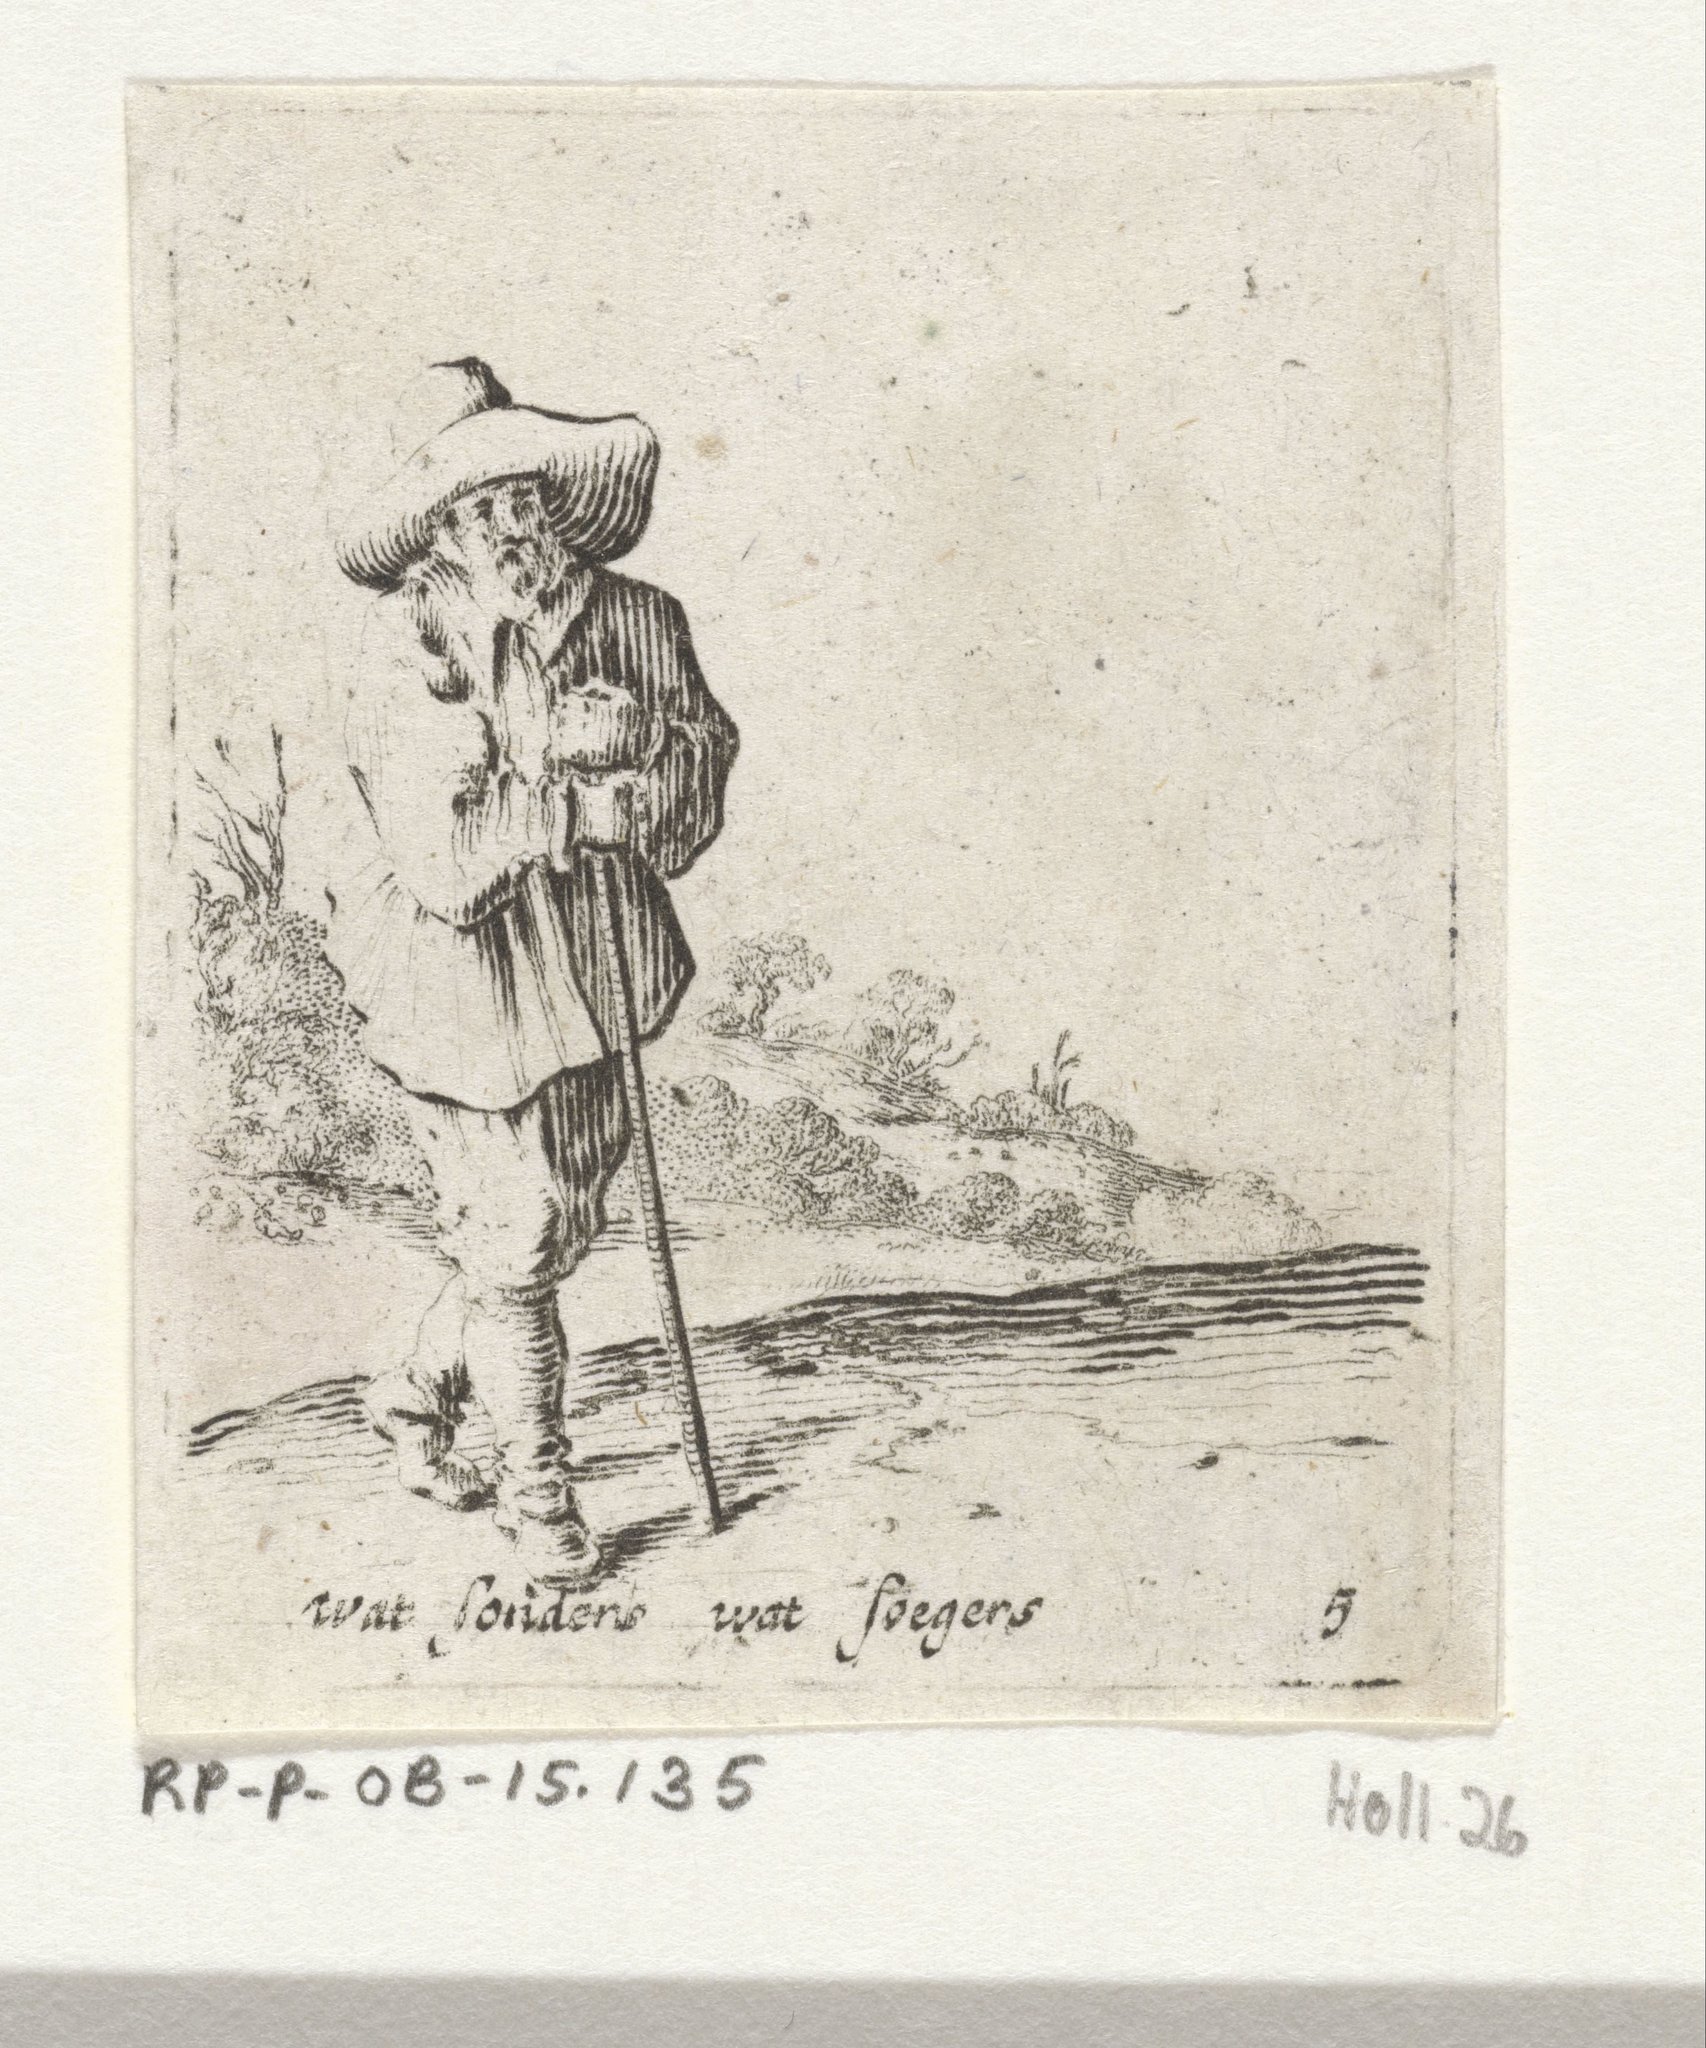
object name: print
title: wat sonders wat soegers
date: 1630-1706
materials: paper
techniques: engraving, etching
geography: amsterdam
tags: walking-stick, staff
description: Een man met op het hoofd een hoed met een brede rand, leunt op een wandelstok. Op de achtergrond een heuvel. De prent maakt deel uit van een serie van 32 prenten met genretaferelen.